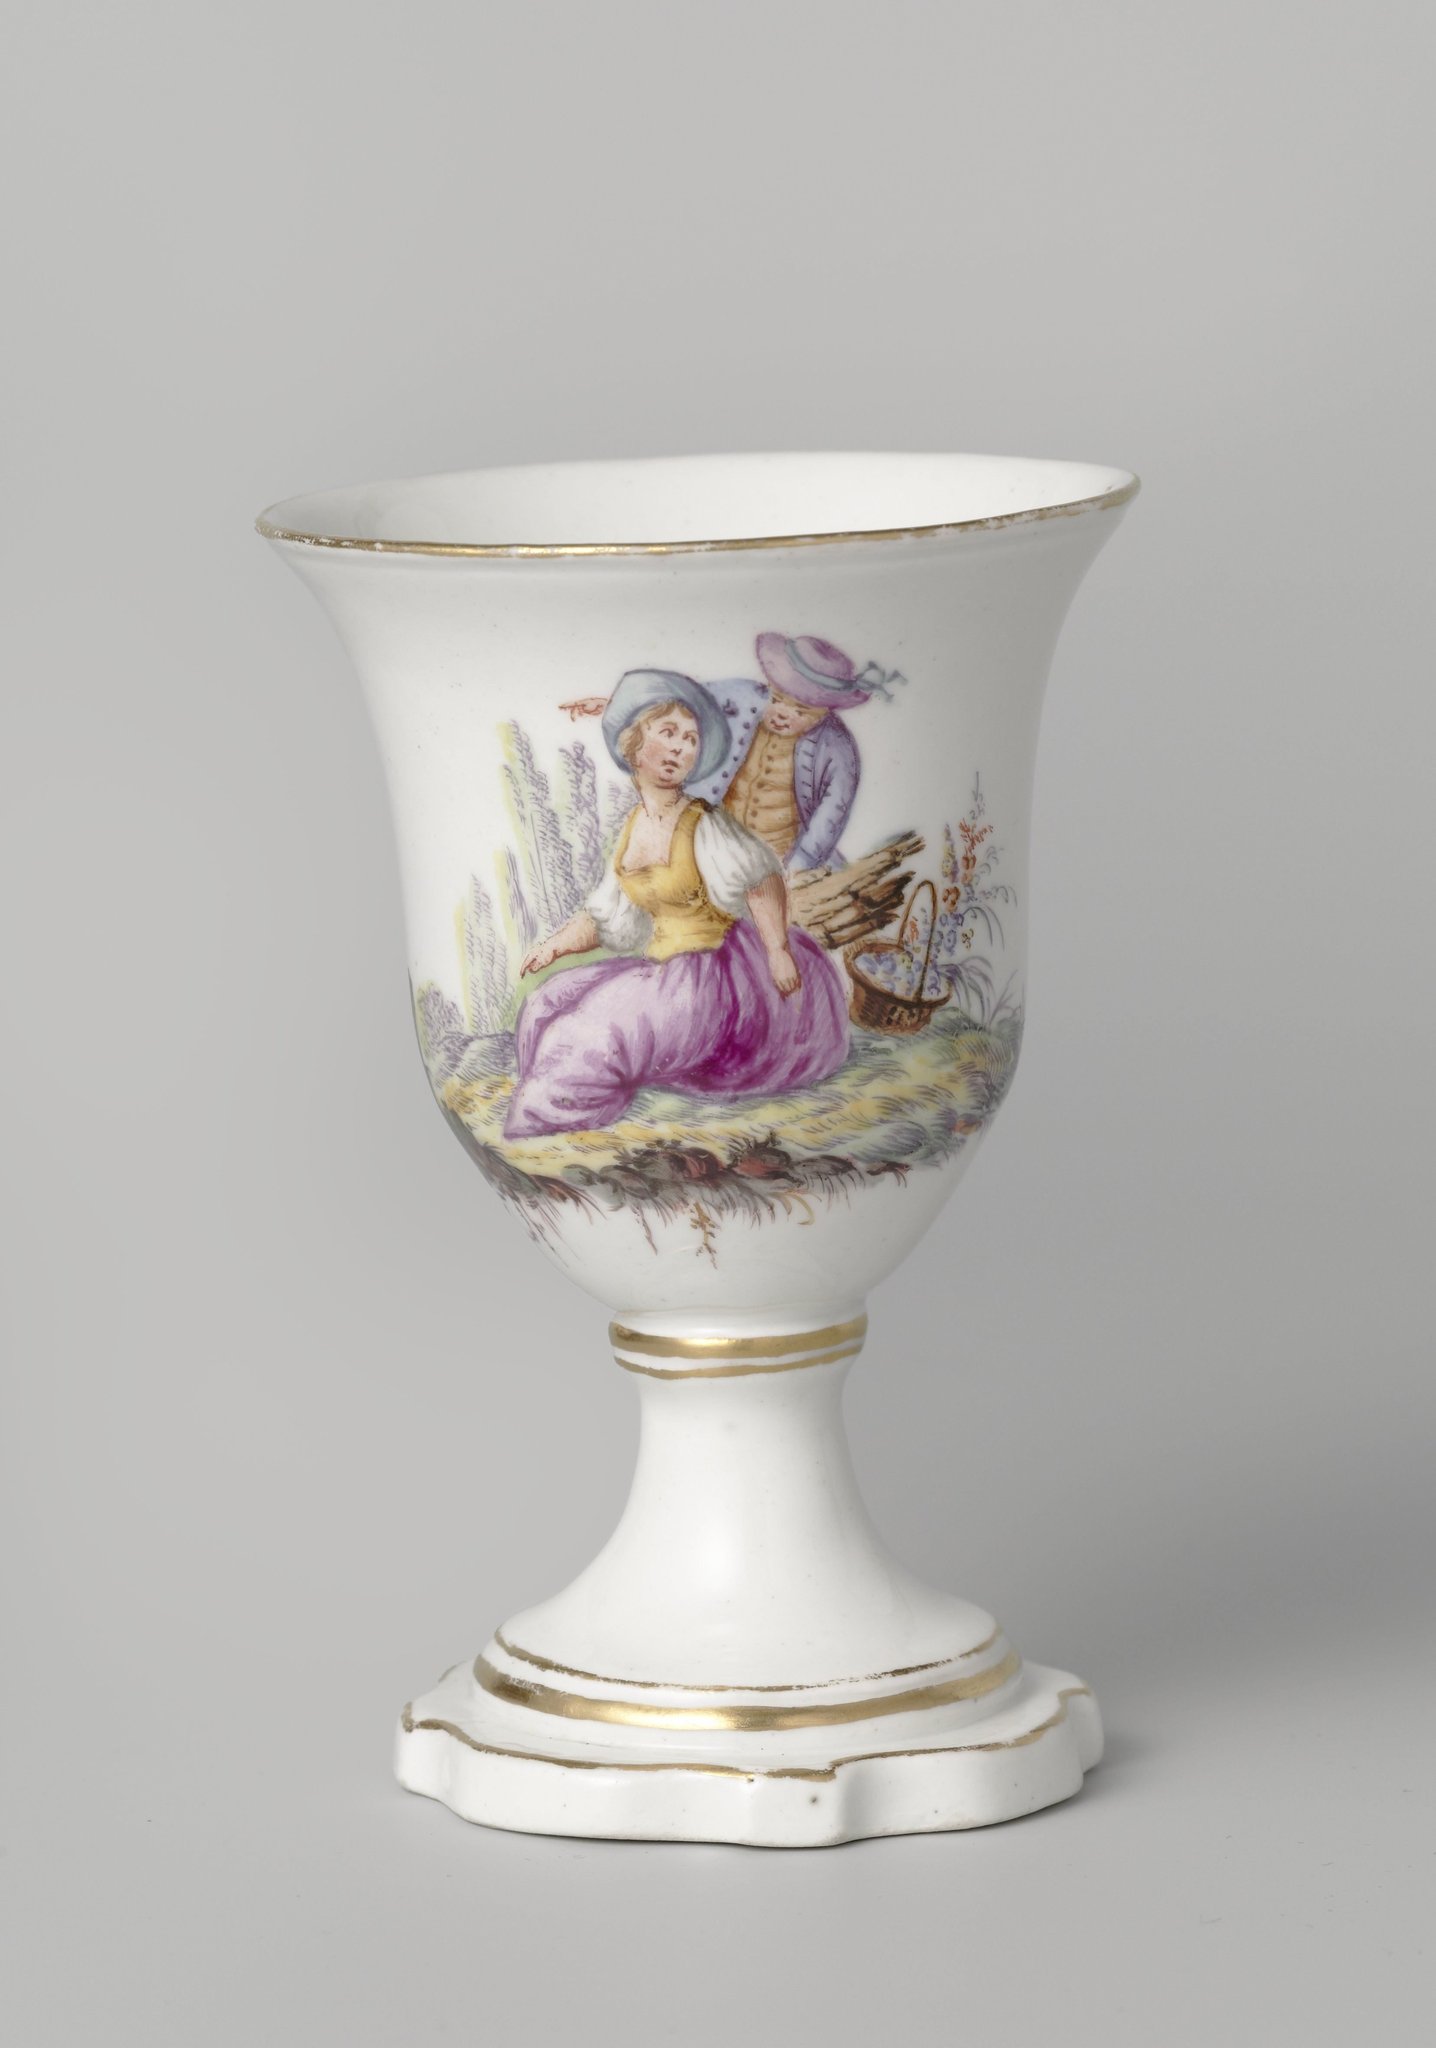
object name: kandeelkop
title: Caudle cup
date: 1774-1778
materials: porcelain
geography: loosdrecht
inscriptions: mark: ‘M:OL // 4 [of] A’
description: Manufactuur Oud-Loosdrecht Loosdrecht, c. 1774–1778 hard-paste porcelain